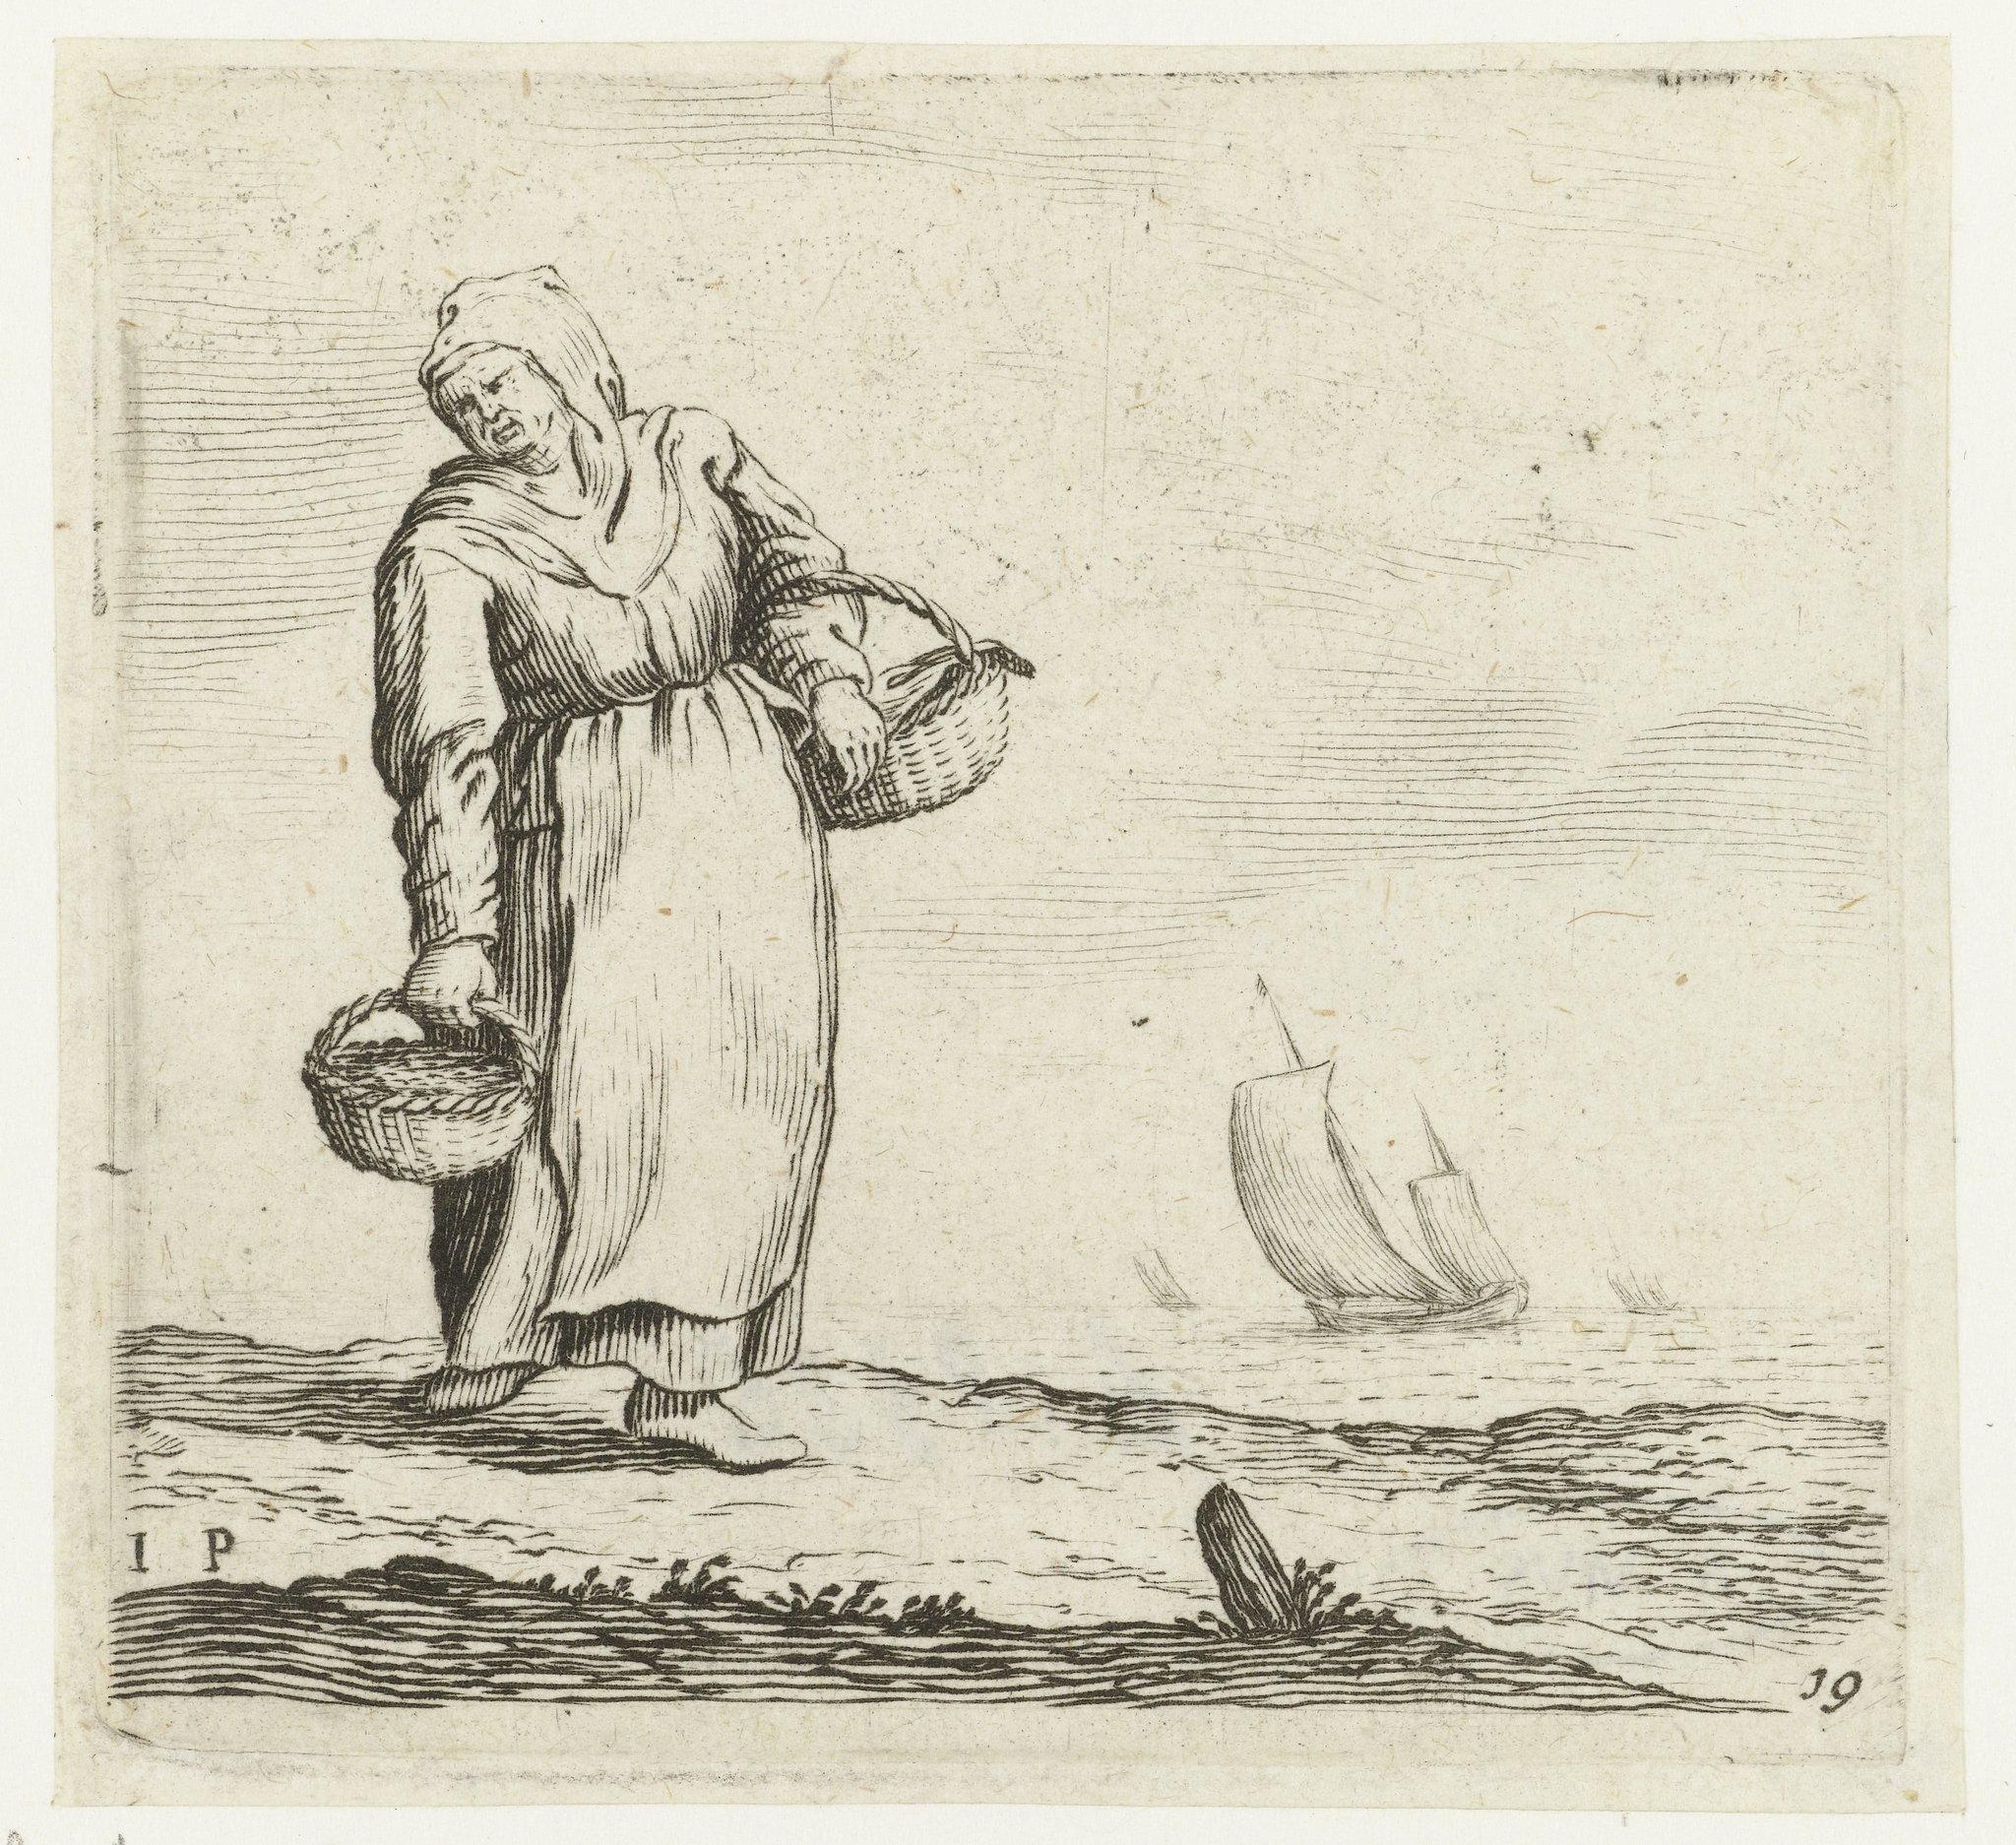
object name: print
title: Verscheyden Stranden en water gesichten gedaen door Jan Percelles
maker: gillis van scheyndel (i)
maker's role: draughtsman, print maker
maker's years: 1595-1660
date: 1603-1653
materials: paper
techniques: etching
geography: northern netherlands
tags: dune coast, container made of plant material other than wood: basket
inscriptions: collector's mark: Lugt 2228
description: De prent is op een gegeven moment toegevoegd aan de serie "Verscheyden Stranden en water gesichten gedaen door Jan Percelles". Op dat moment is het serienummer gewijzigd.